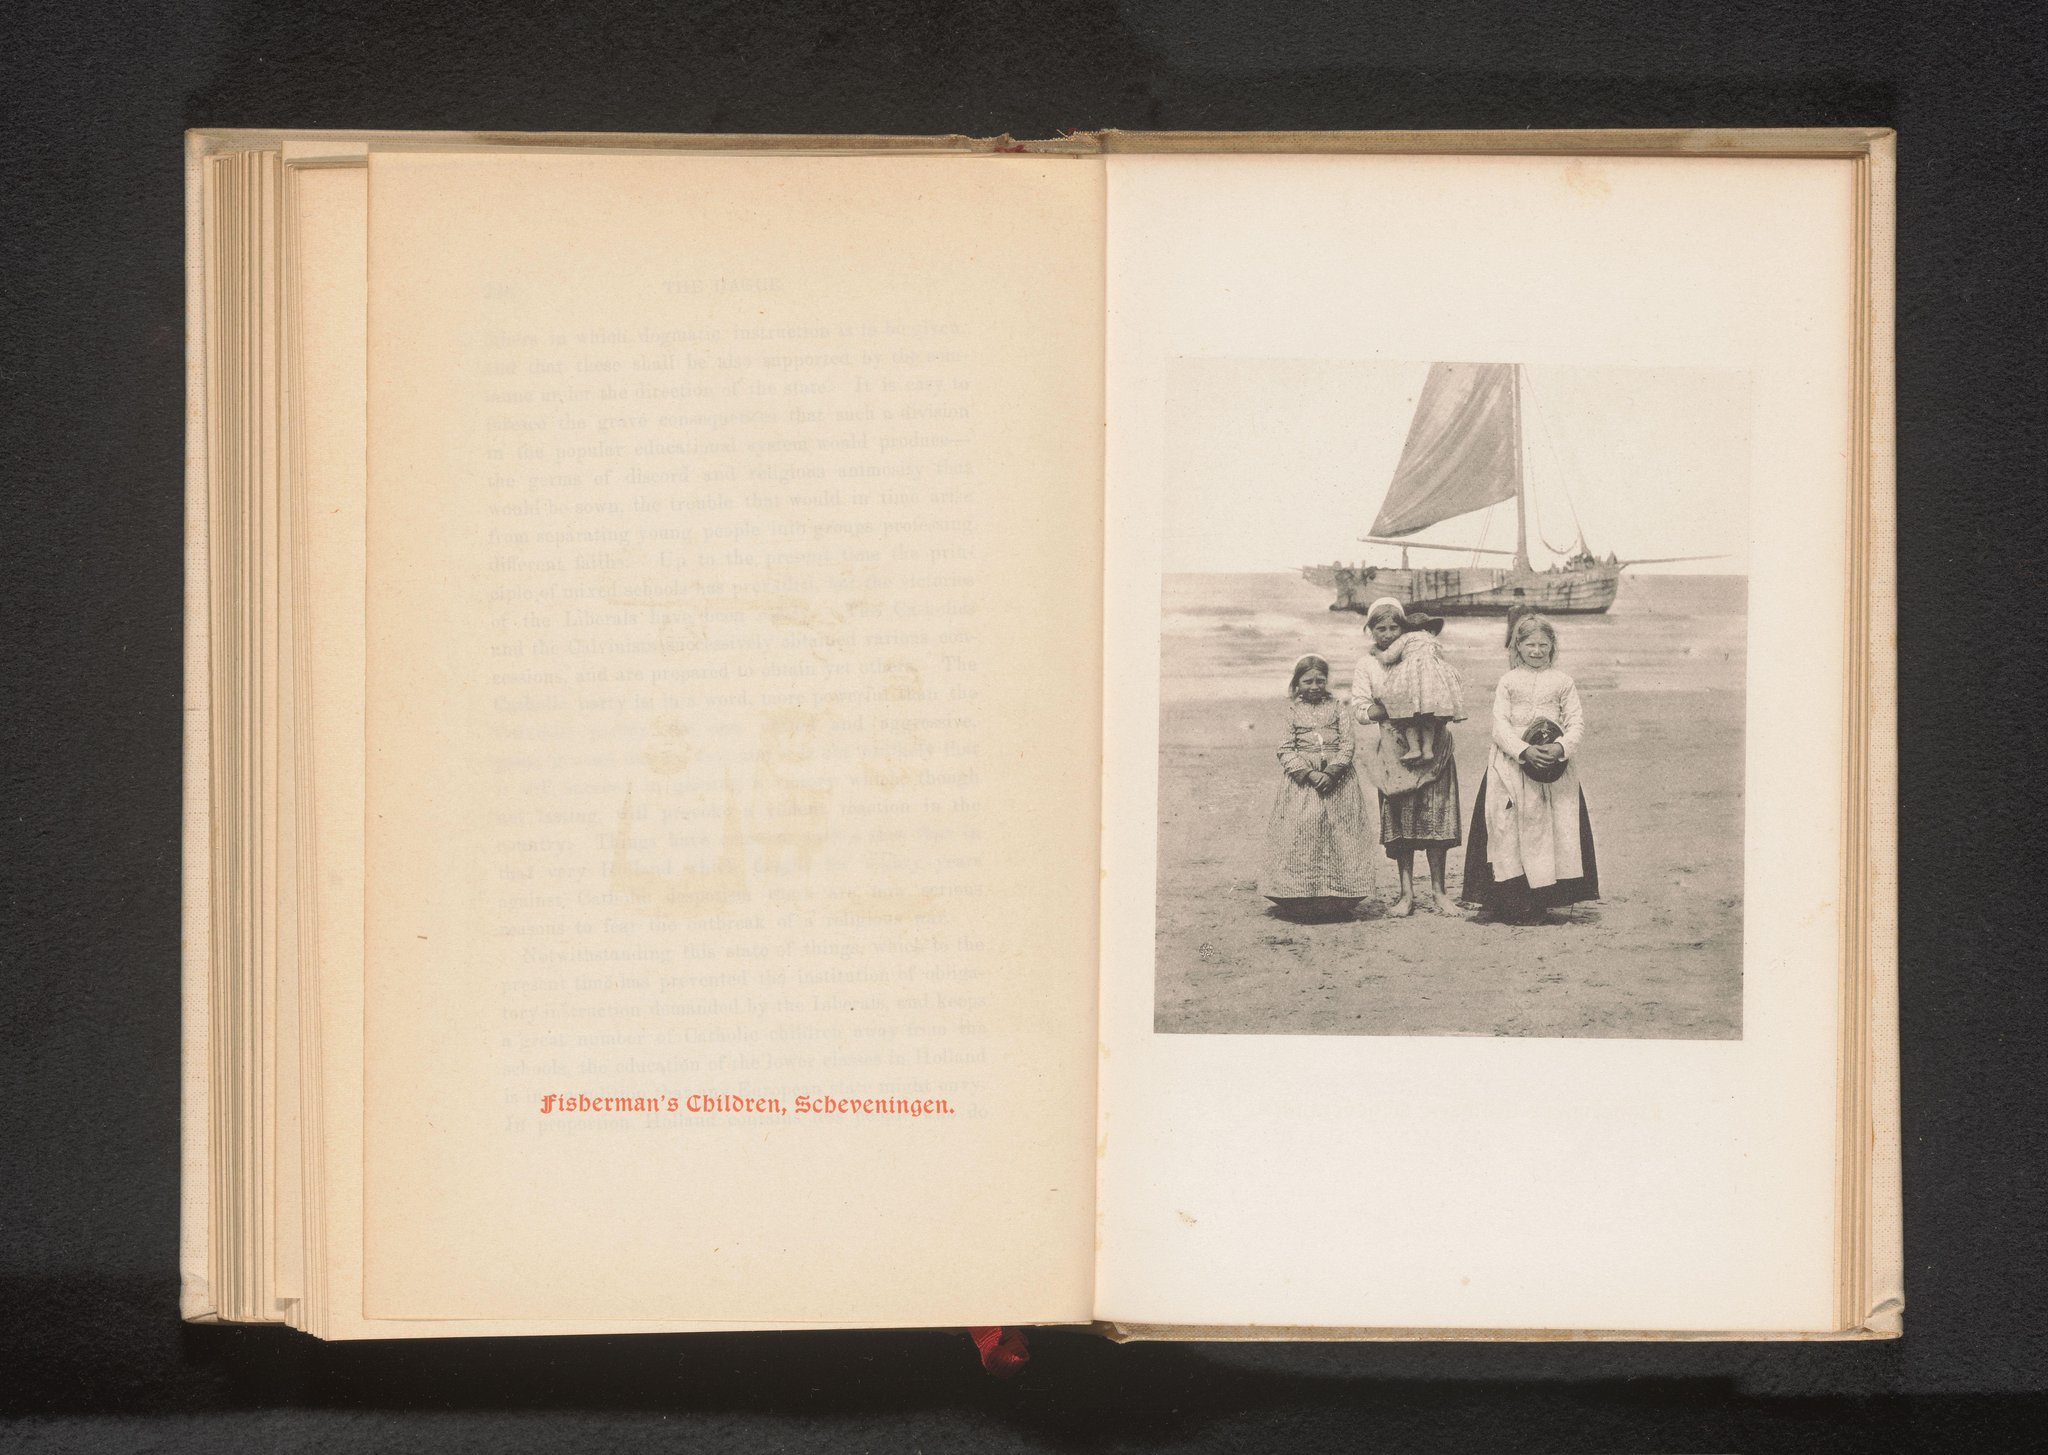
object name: photomechanical print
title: Kinderen van vissers op het strand van Scheveningen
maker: charles l. mitchell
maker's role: fotograaf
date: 1884-1894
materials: paper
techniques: photoaquatint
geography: scheveningen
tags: child, beach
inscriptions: title: ‘Fisherman's Children, Scheveningen.’